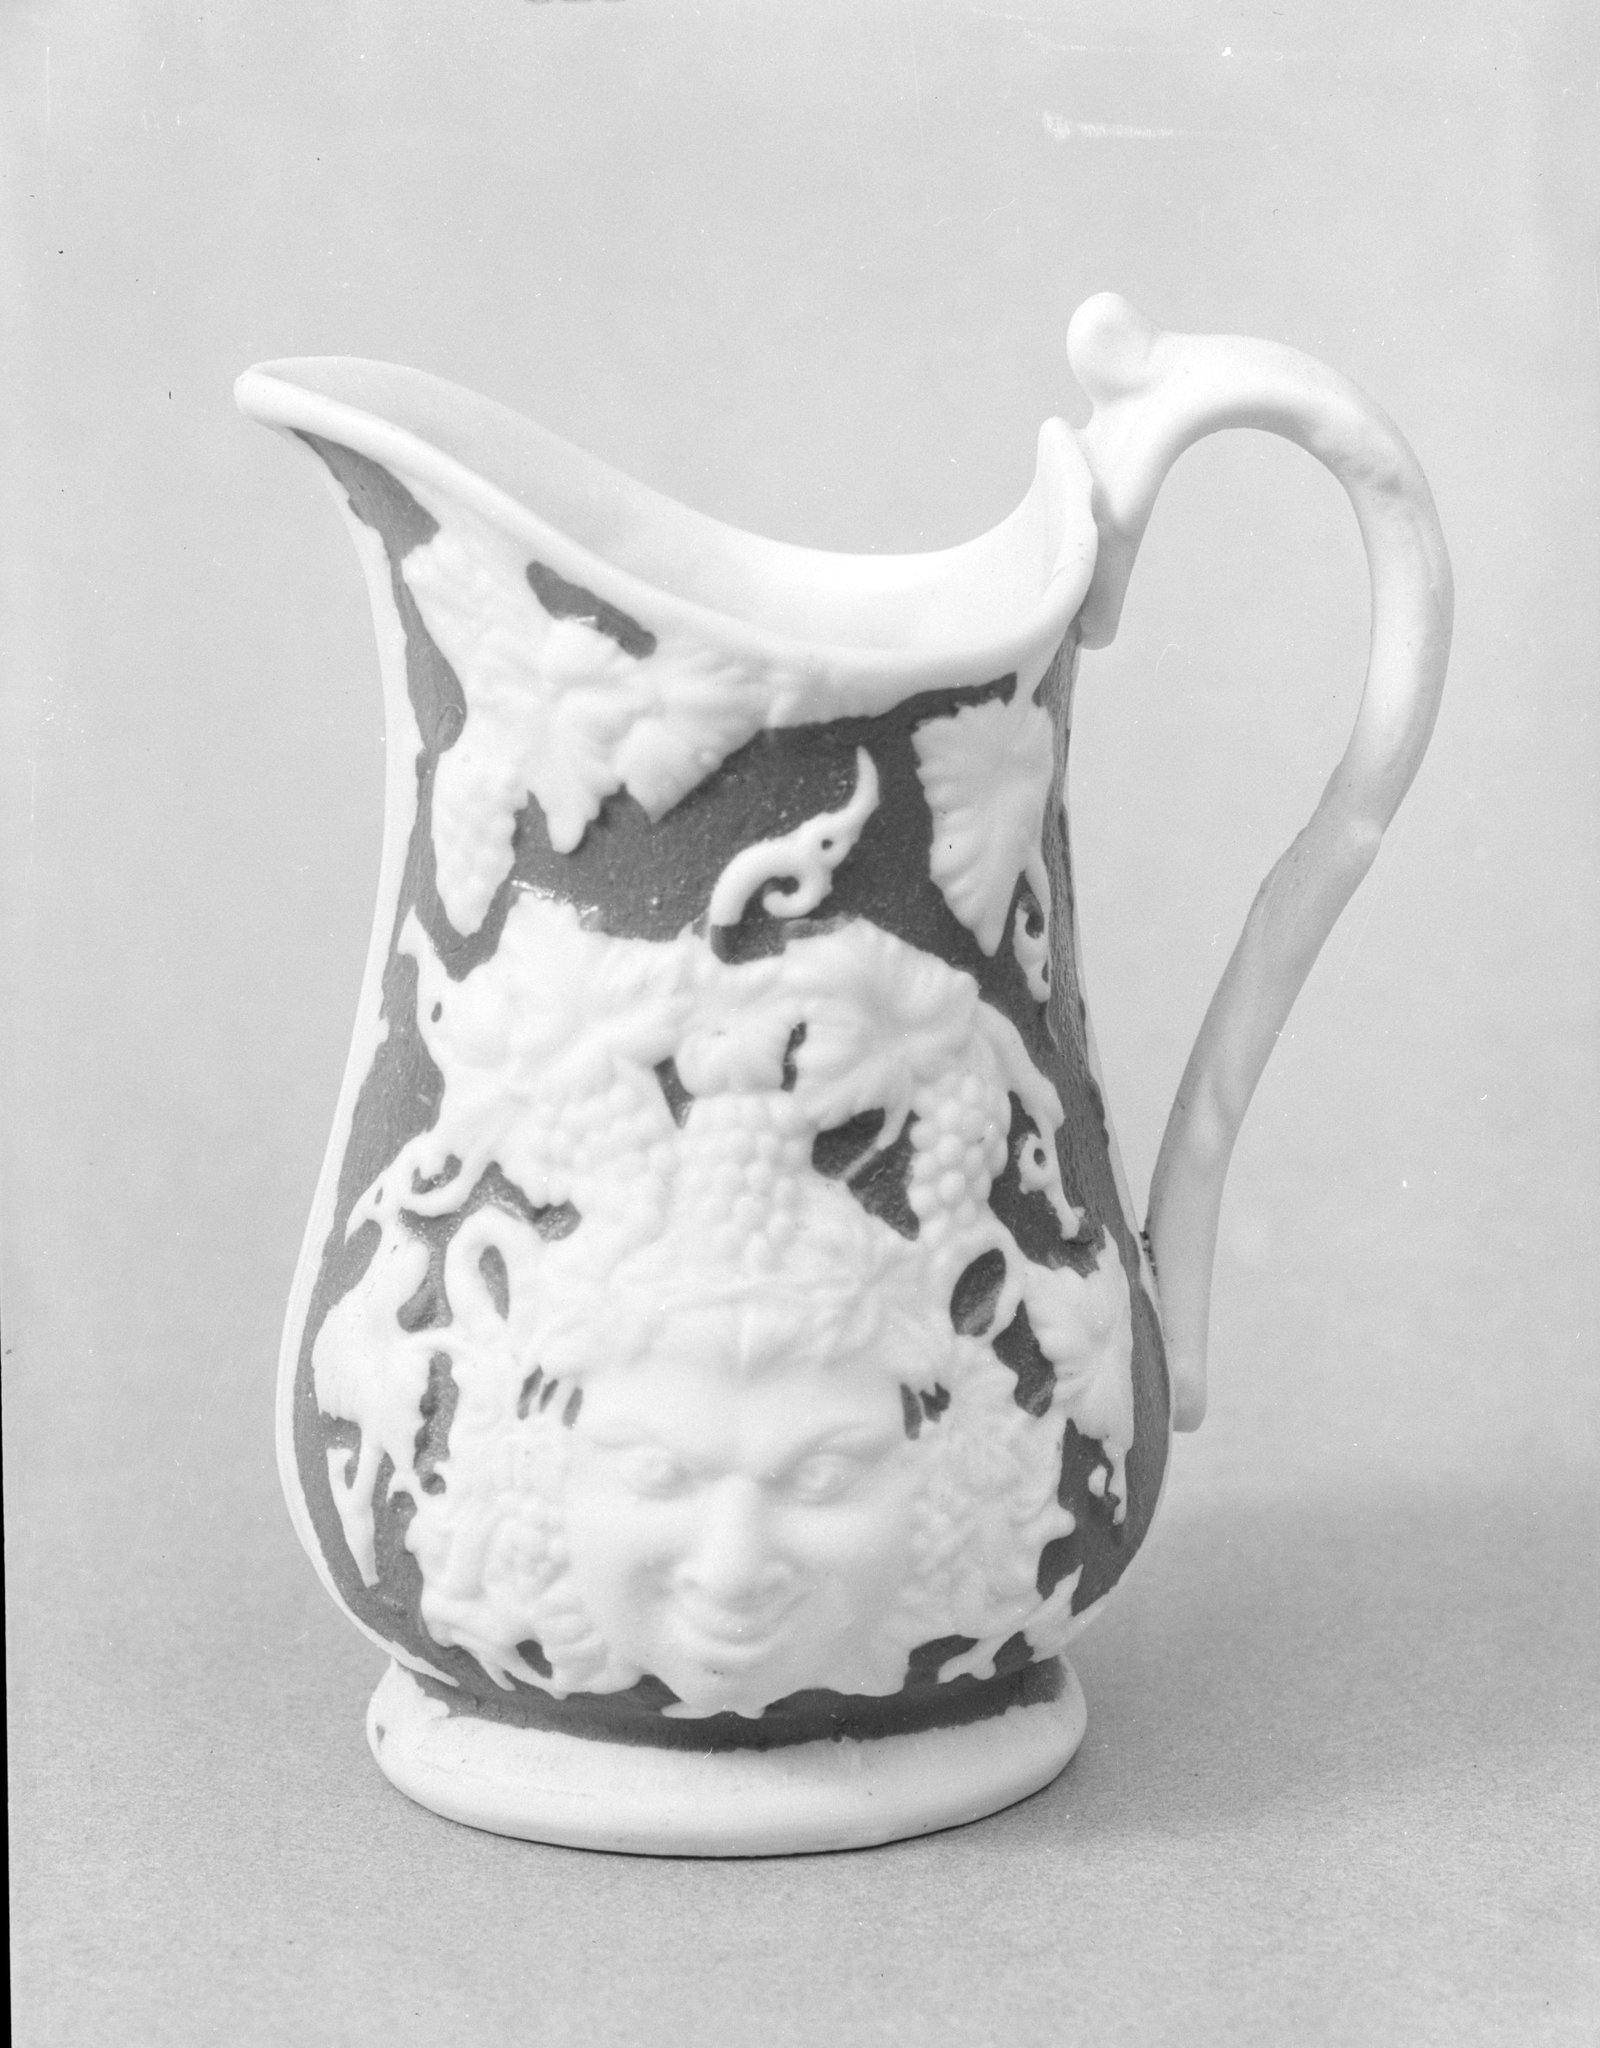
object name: pitcher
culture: american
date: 1830-1870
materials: porcelain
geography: united states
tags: masks,grapes